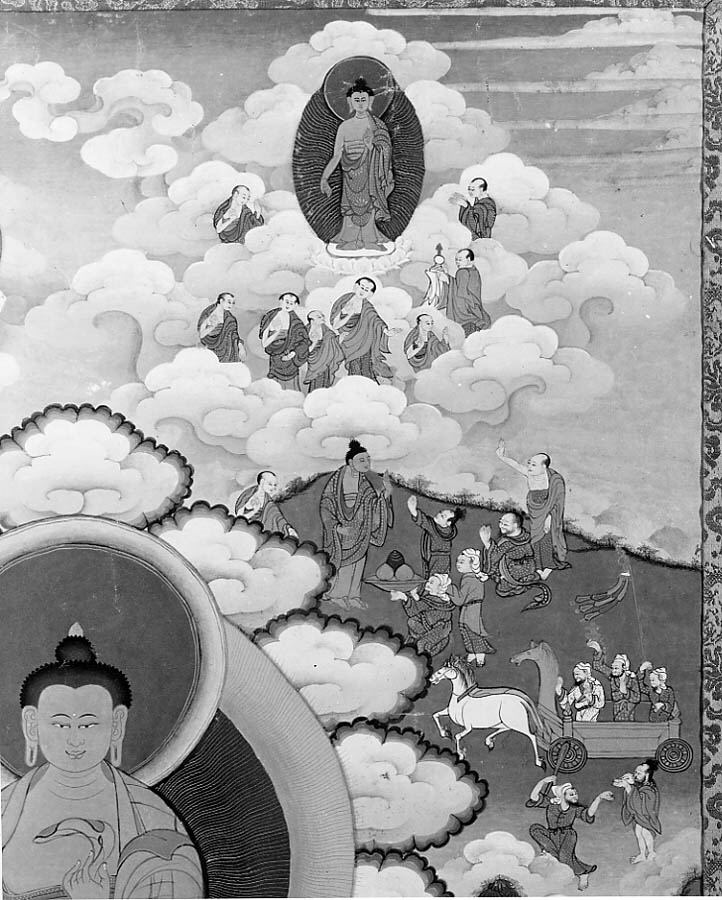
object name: thangka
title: Thanka with Large Buddha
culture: tibetan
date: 1801-1900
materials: textile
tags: horses,clouds,buddhism,buddha,monks,carts